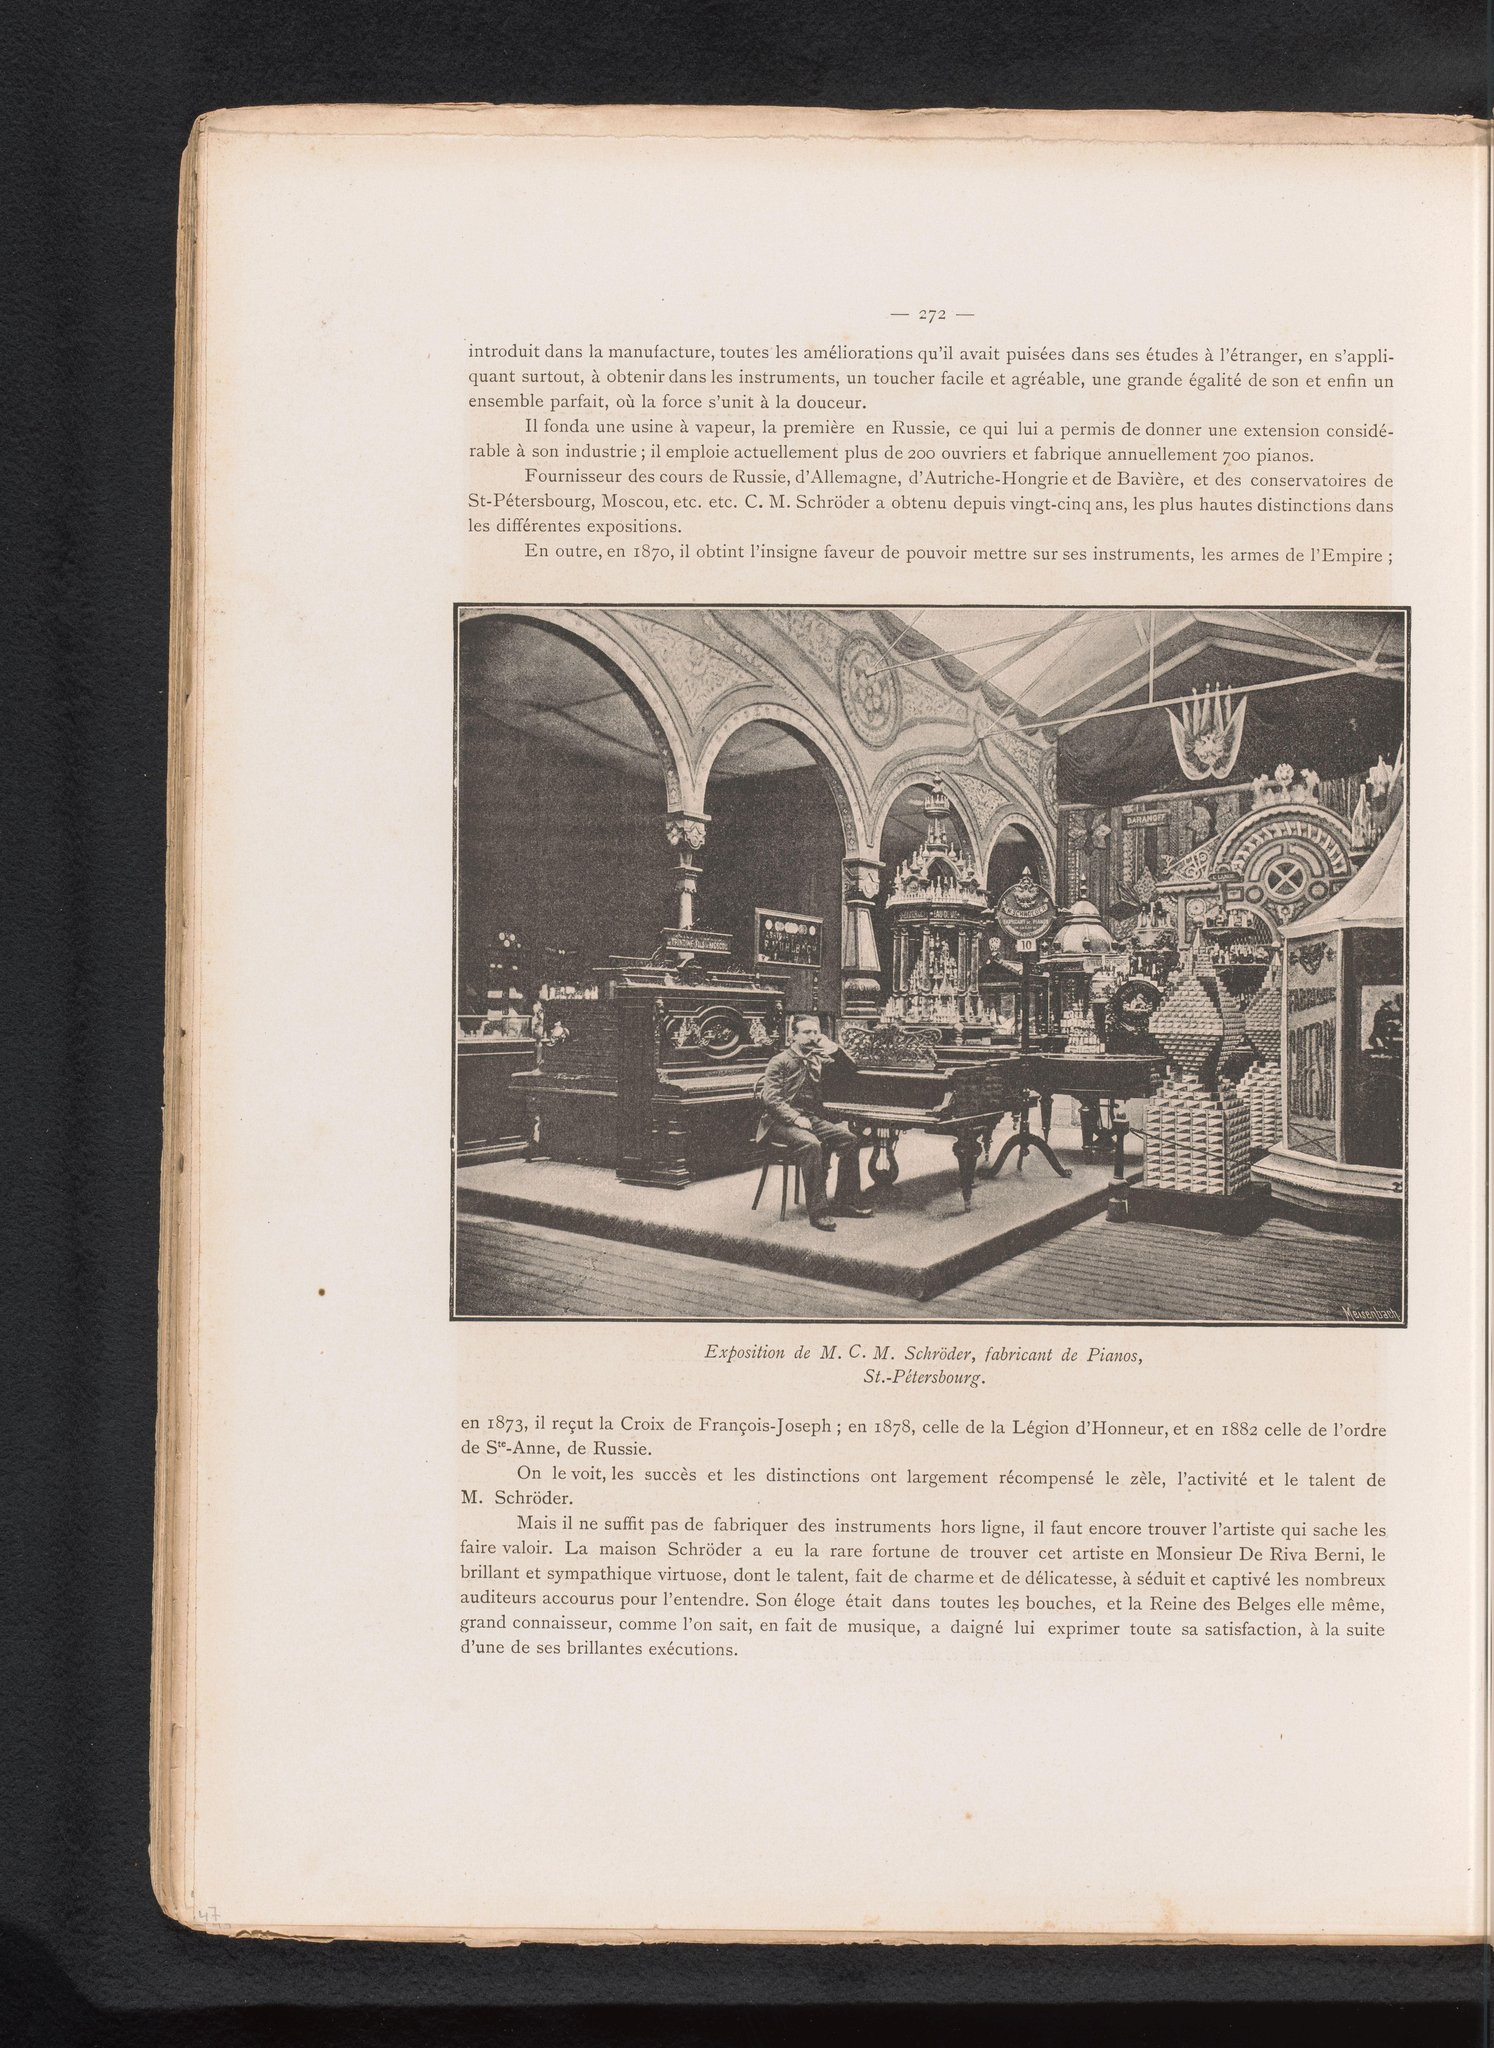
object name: photomechanical print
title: Gezicht op de opstelling van pianomaker C.M. Schröder op de Wereldtentoonstelling van 1885 in Antwerpen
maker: Anonymous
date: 1880-1885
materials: paper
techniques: autotype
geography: antwerp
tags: grand piano, world fair, world exhibition, antwerp